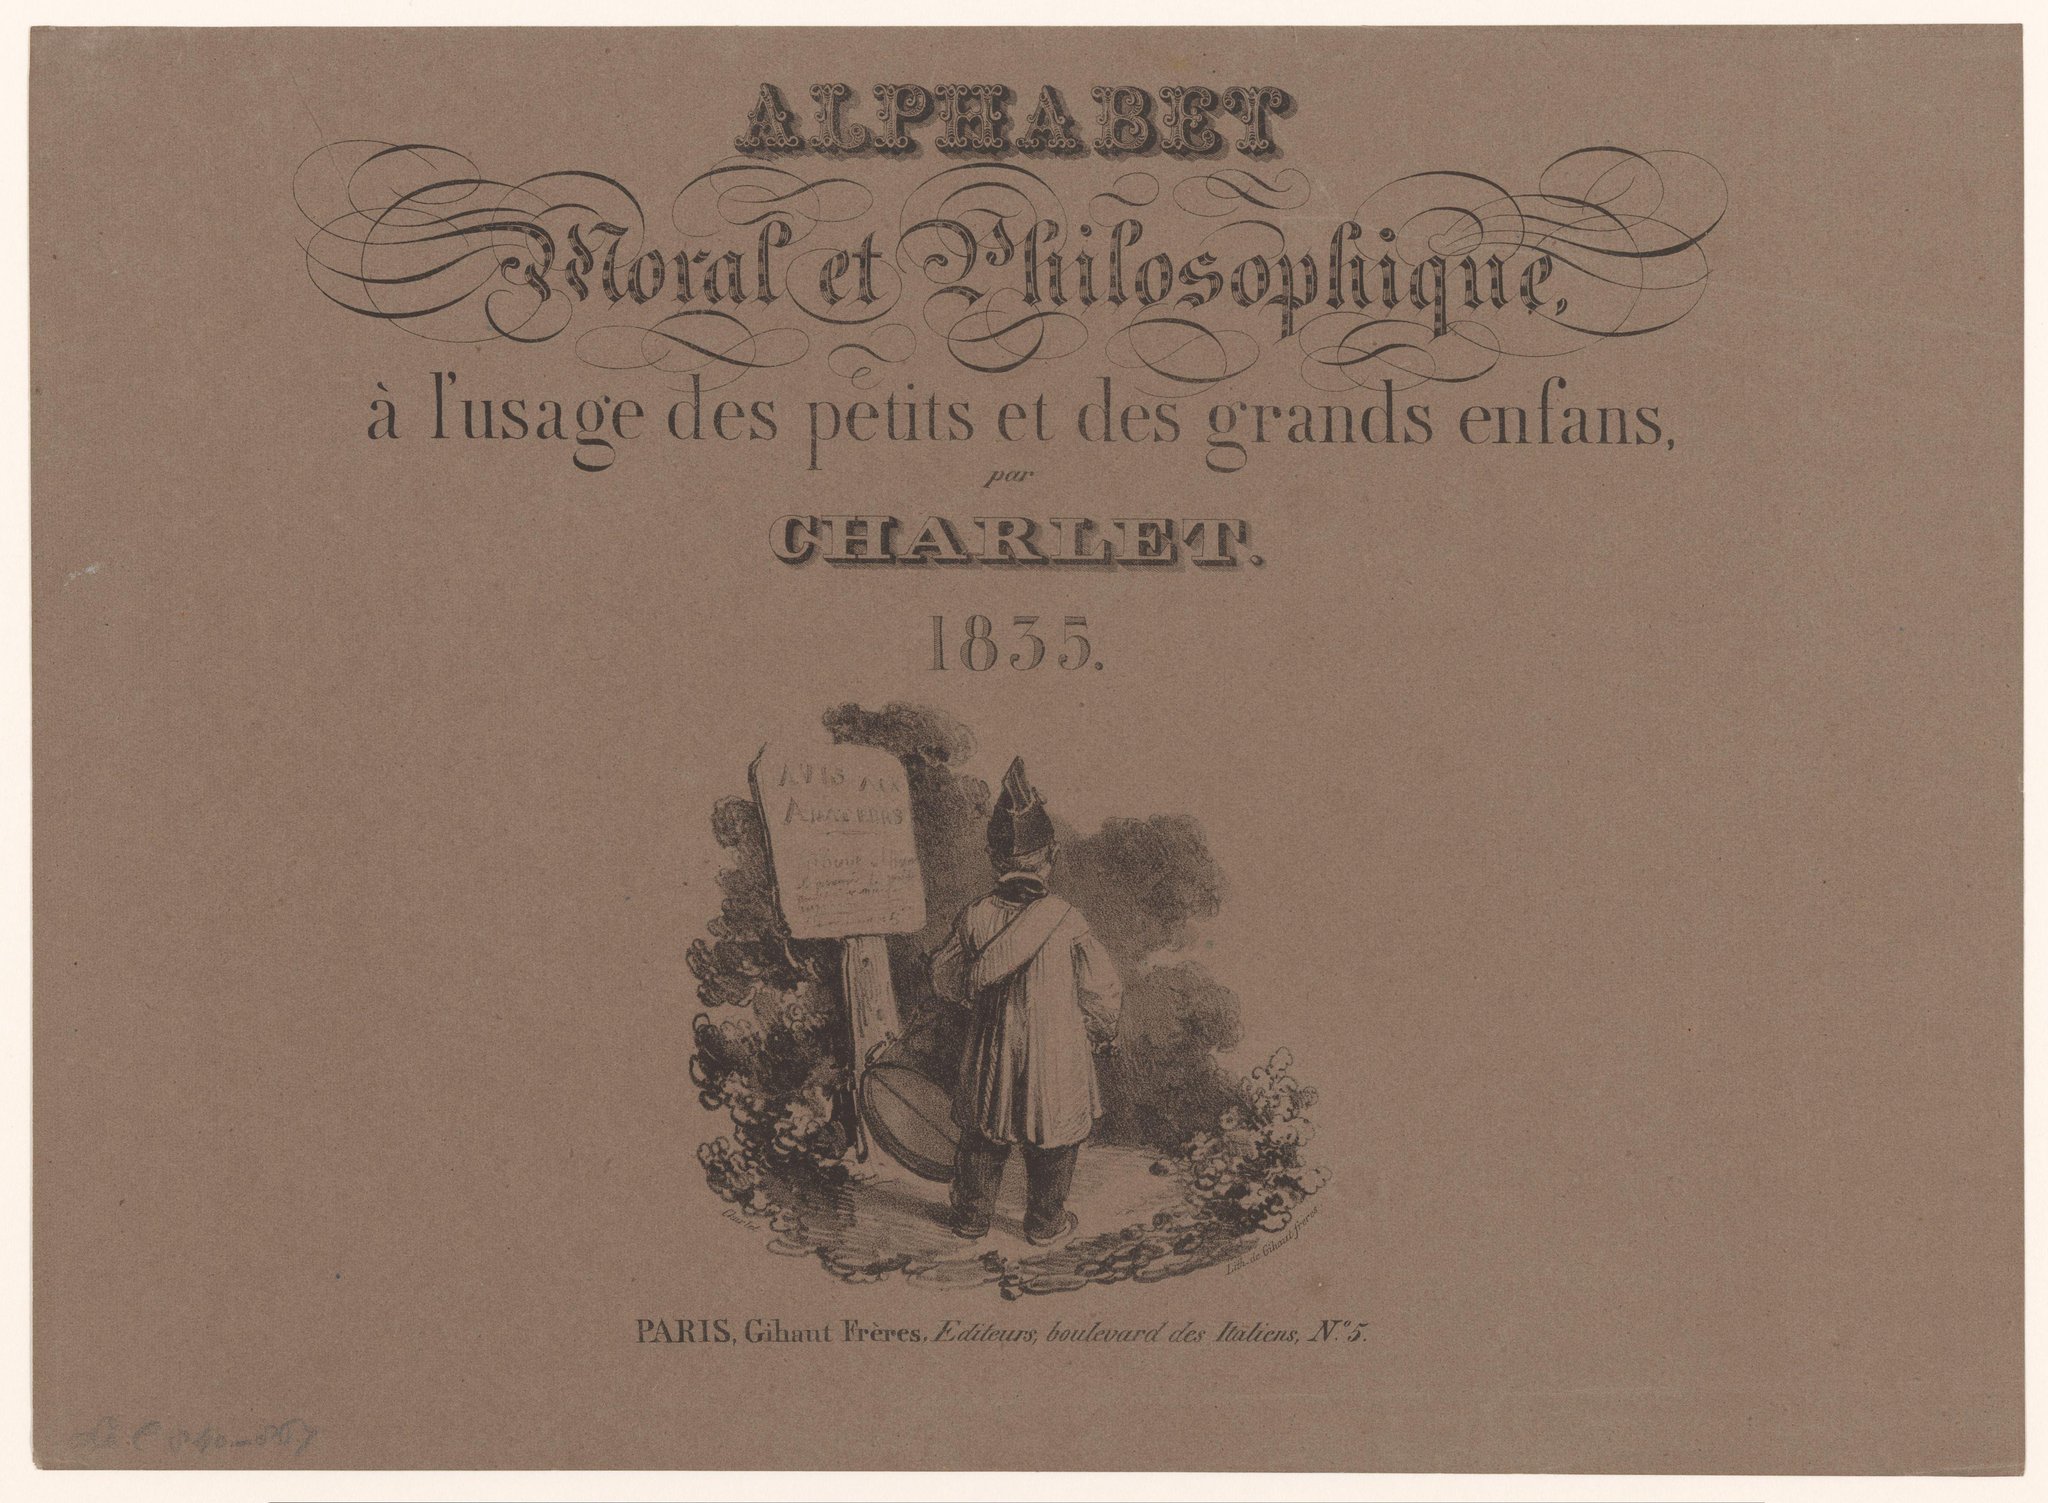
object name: wrapper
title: Omslag voor: Alfabet met een moraal voor kinderen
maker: nicolas toussaint charlet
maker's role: draughtsman, painter, print maker, printer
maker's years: 1792-1845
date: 1835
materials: paper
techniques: lithograph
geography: paris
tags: boy (child between toddler and youth), calligraphy, drum (musical instrument) - cc - out of doors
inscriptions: collector's mark: Lugt 2228a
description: Omslag met 25 prenten, genummerd 1 tot en met 25.